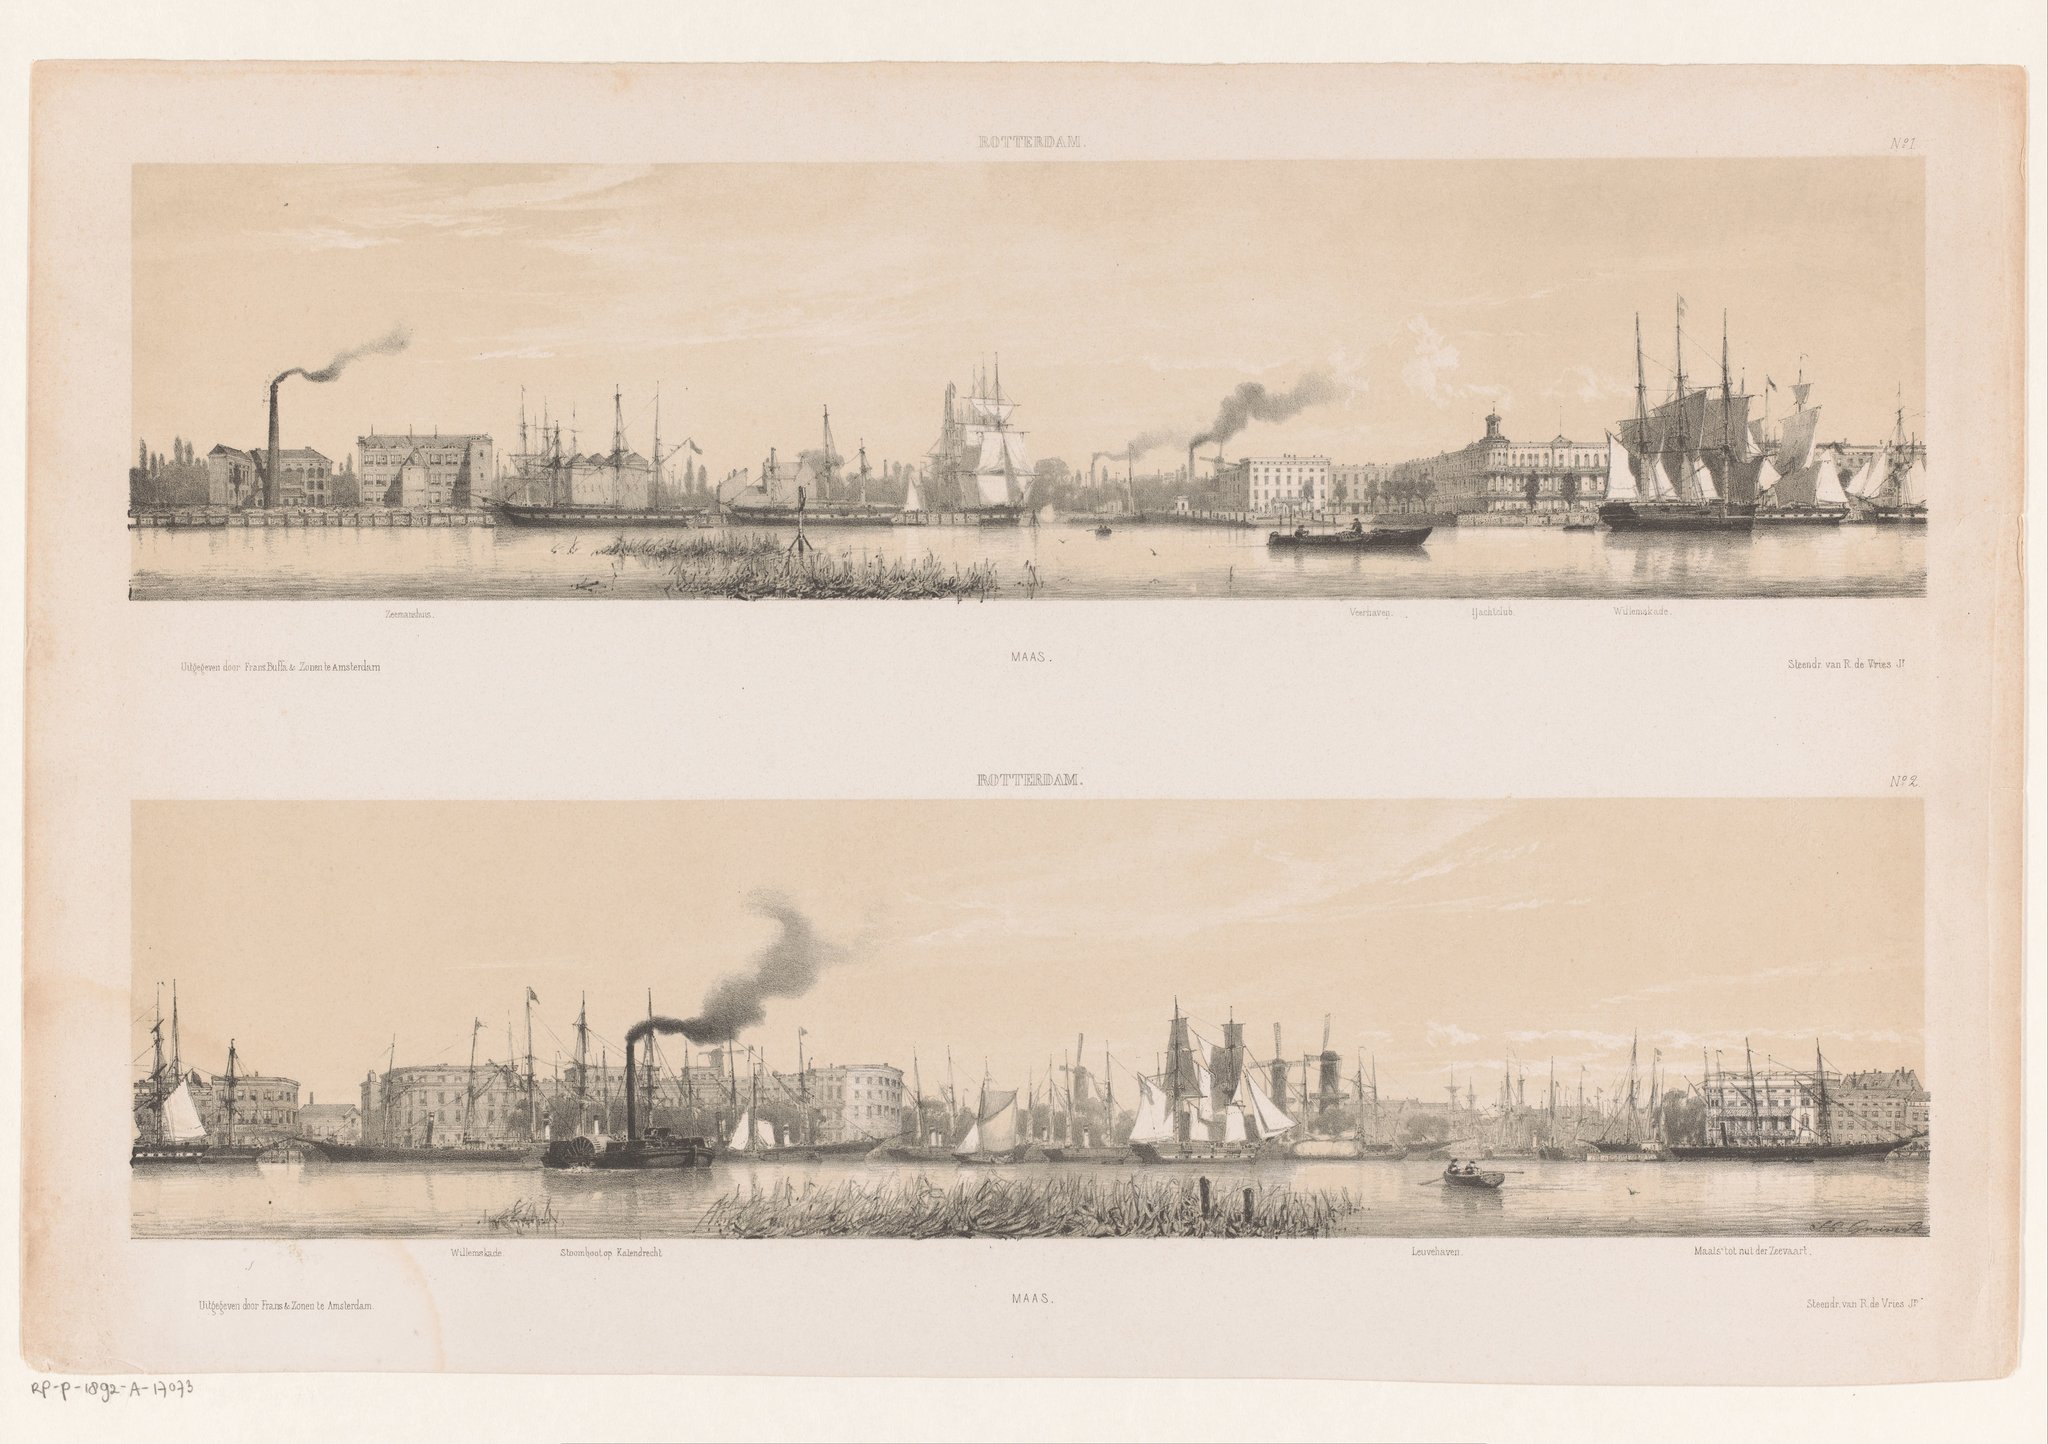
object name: print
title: Profiel van Rotterdam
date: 1860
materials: paper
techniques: tone lithography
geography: amsterdam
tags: prospect of city, town panorama, silhouette of city, rotterdam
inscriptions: collector's mark: Lugt 2228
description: De stad is vanaf de Maas gezien. In het bovenste profiel zijn het Zeemanshuis, de Veerhaven, de Jachtclub en de Willemskade afgebeeld. Het tweede profiel daaronder gaat door met de Willemskade, een stoomboot, Leuvehaven en de Maatschappij tot Nut van de Scheepvaart. Beiden profielen zijn rechtsboven genummerd.